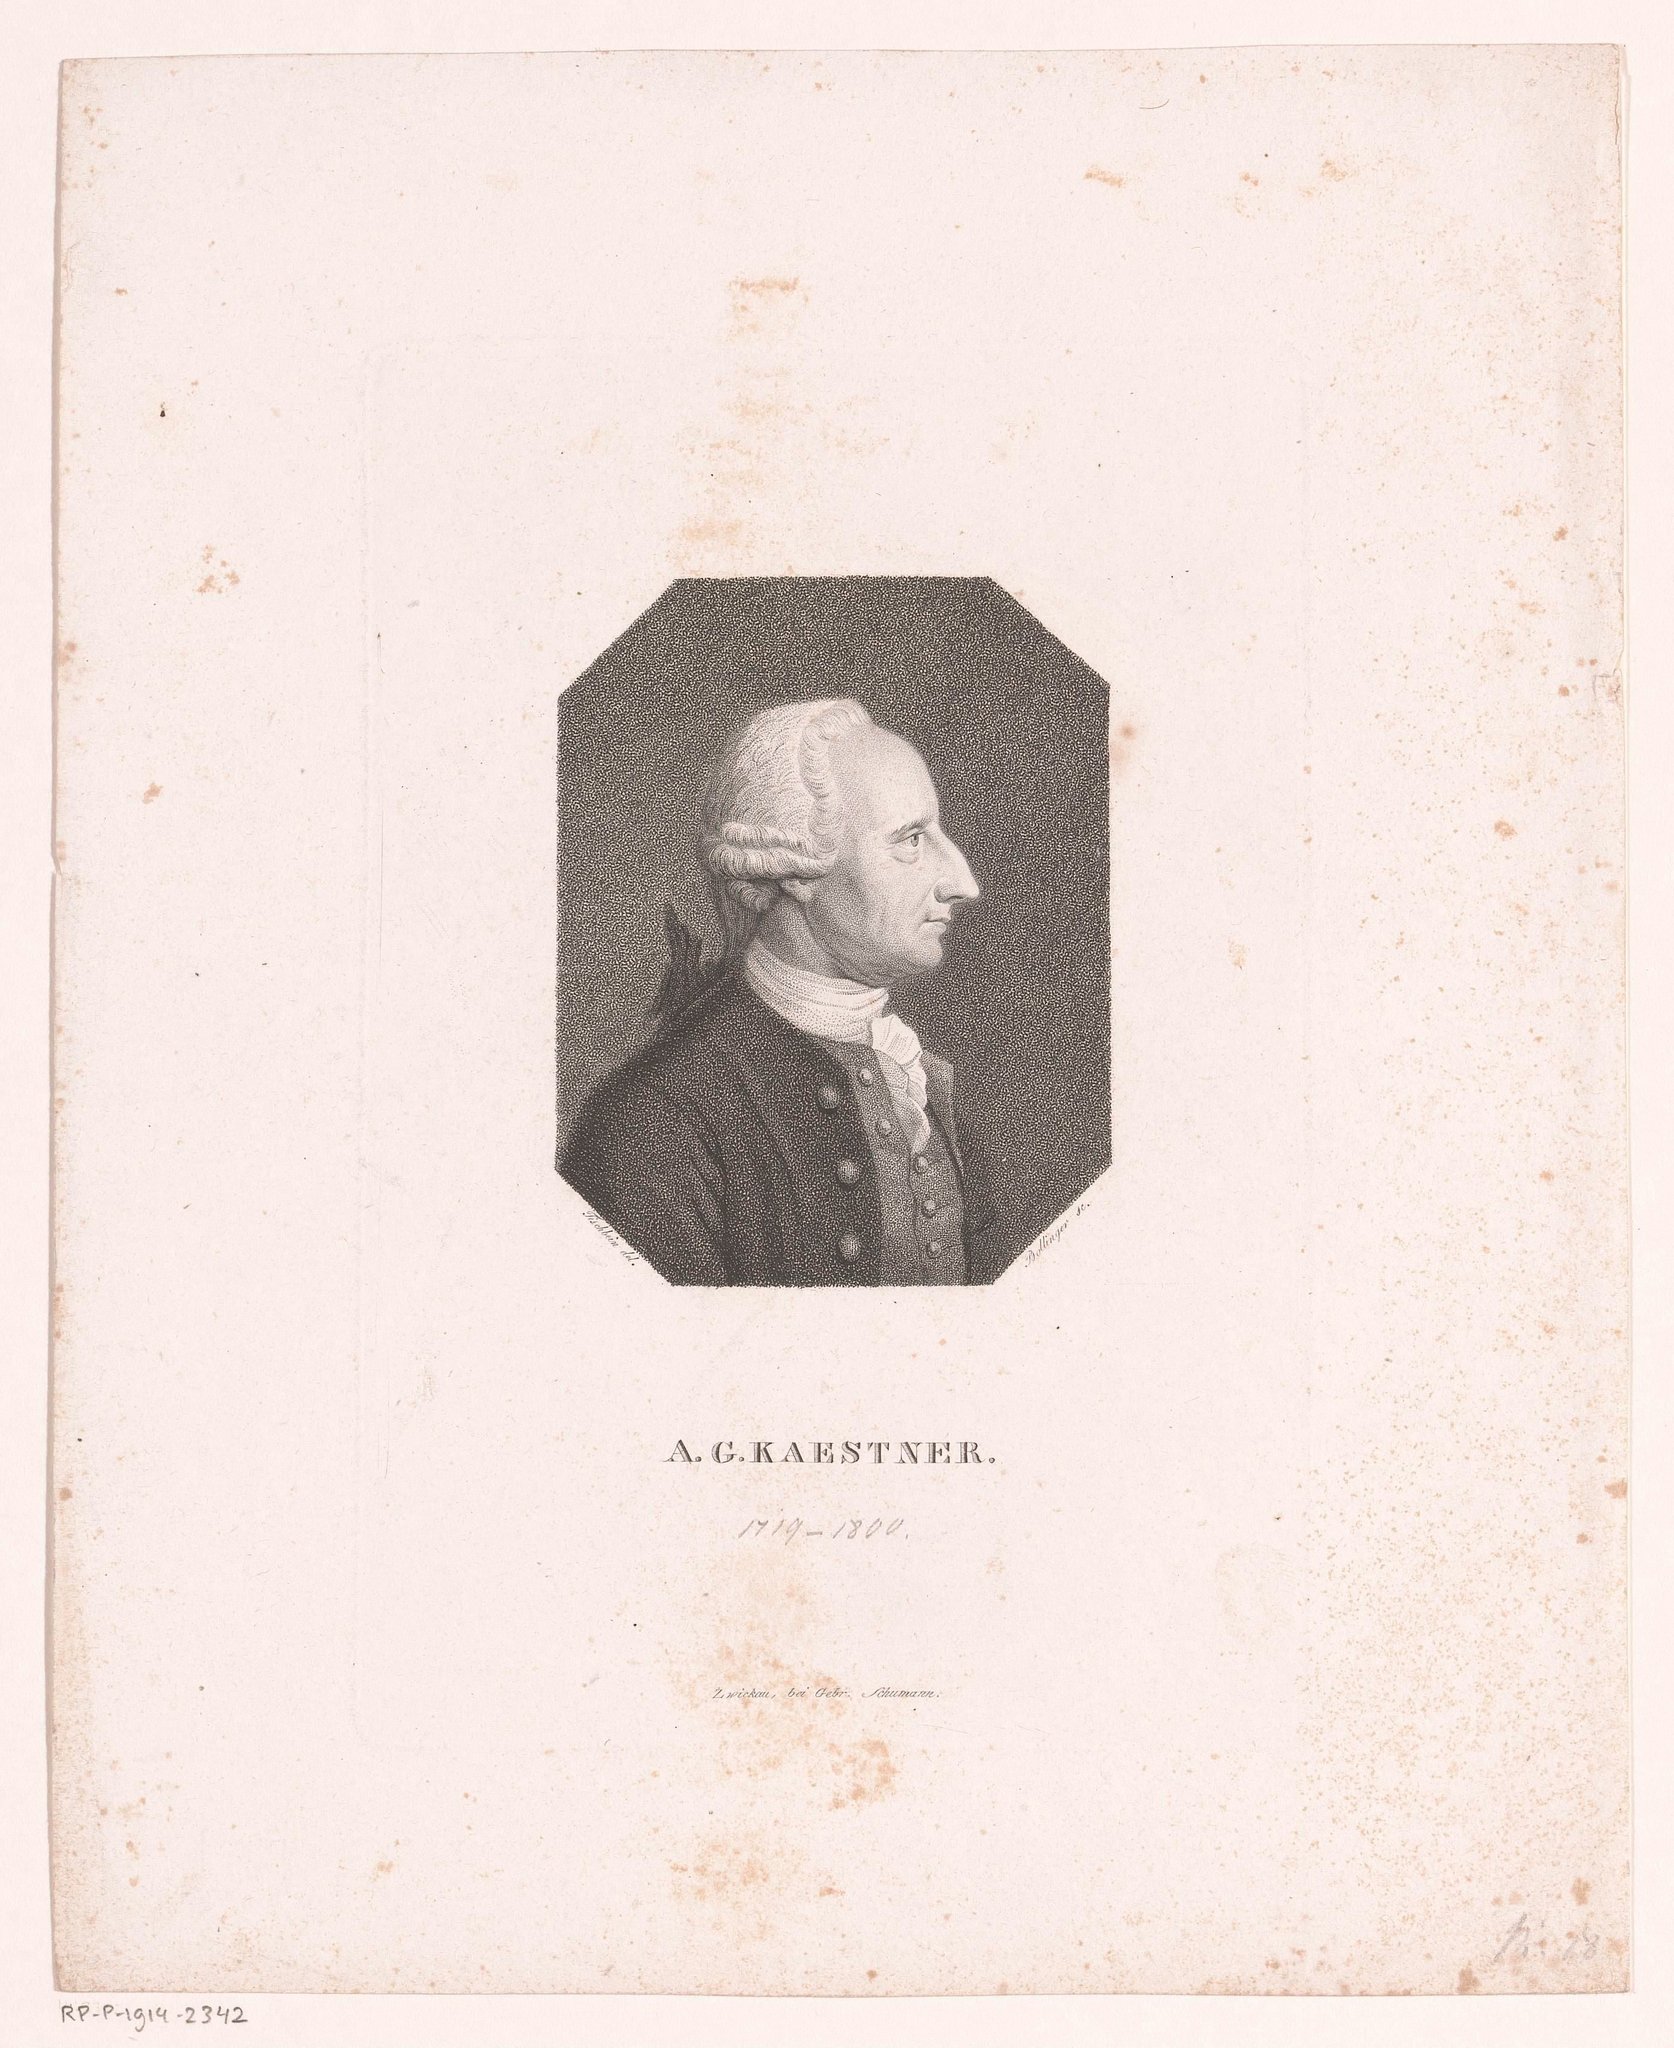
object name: print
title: Portretten van beroemde mensen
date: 1818-1832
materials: paper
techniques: stippling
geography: berlin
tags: historical persons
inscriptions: collector's mark: Lugt 2228